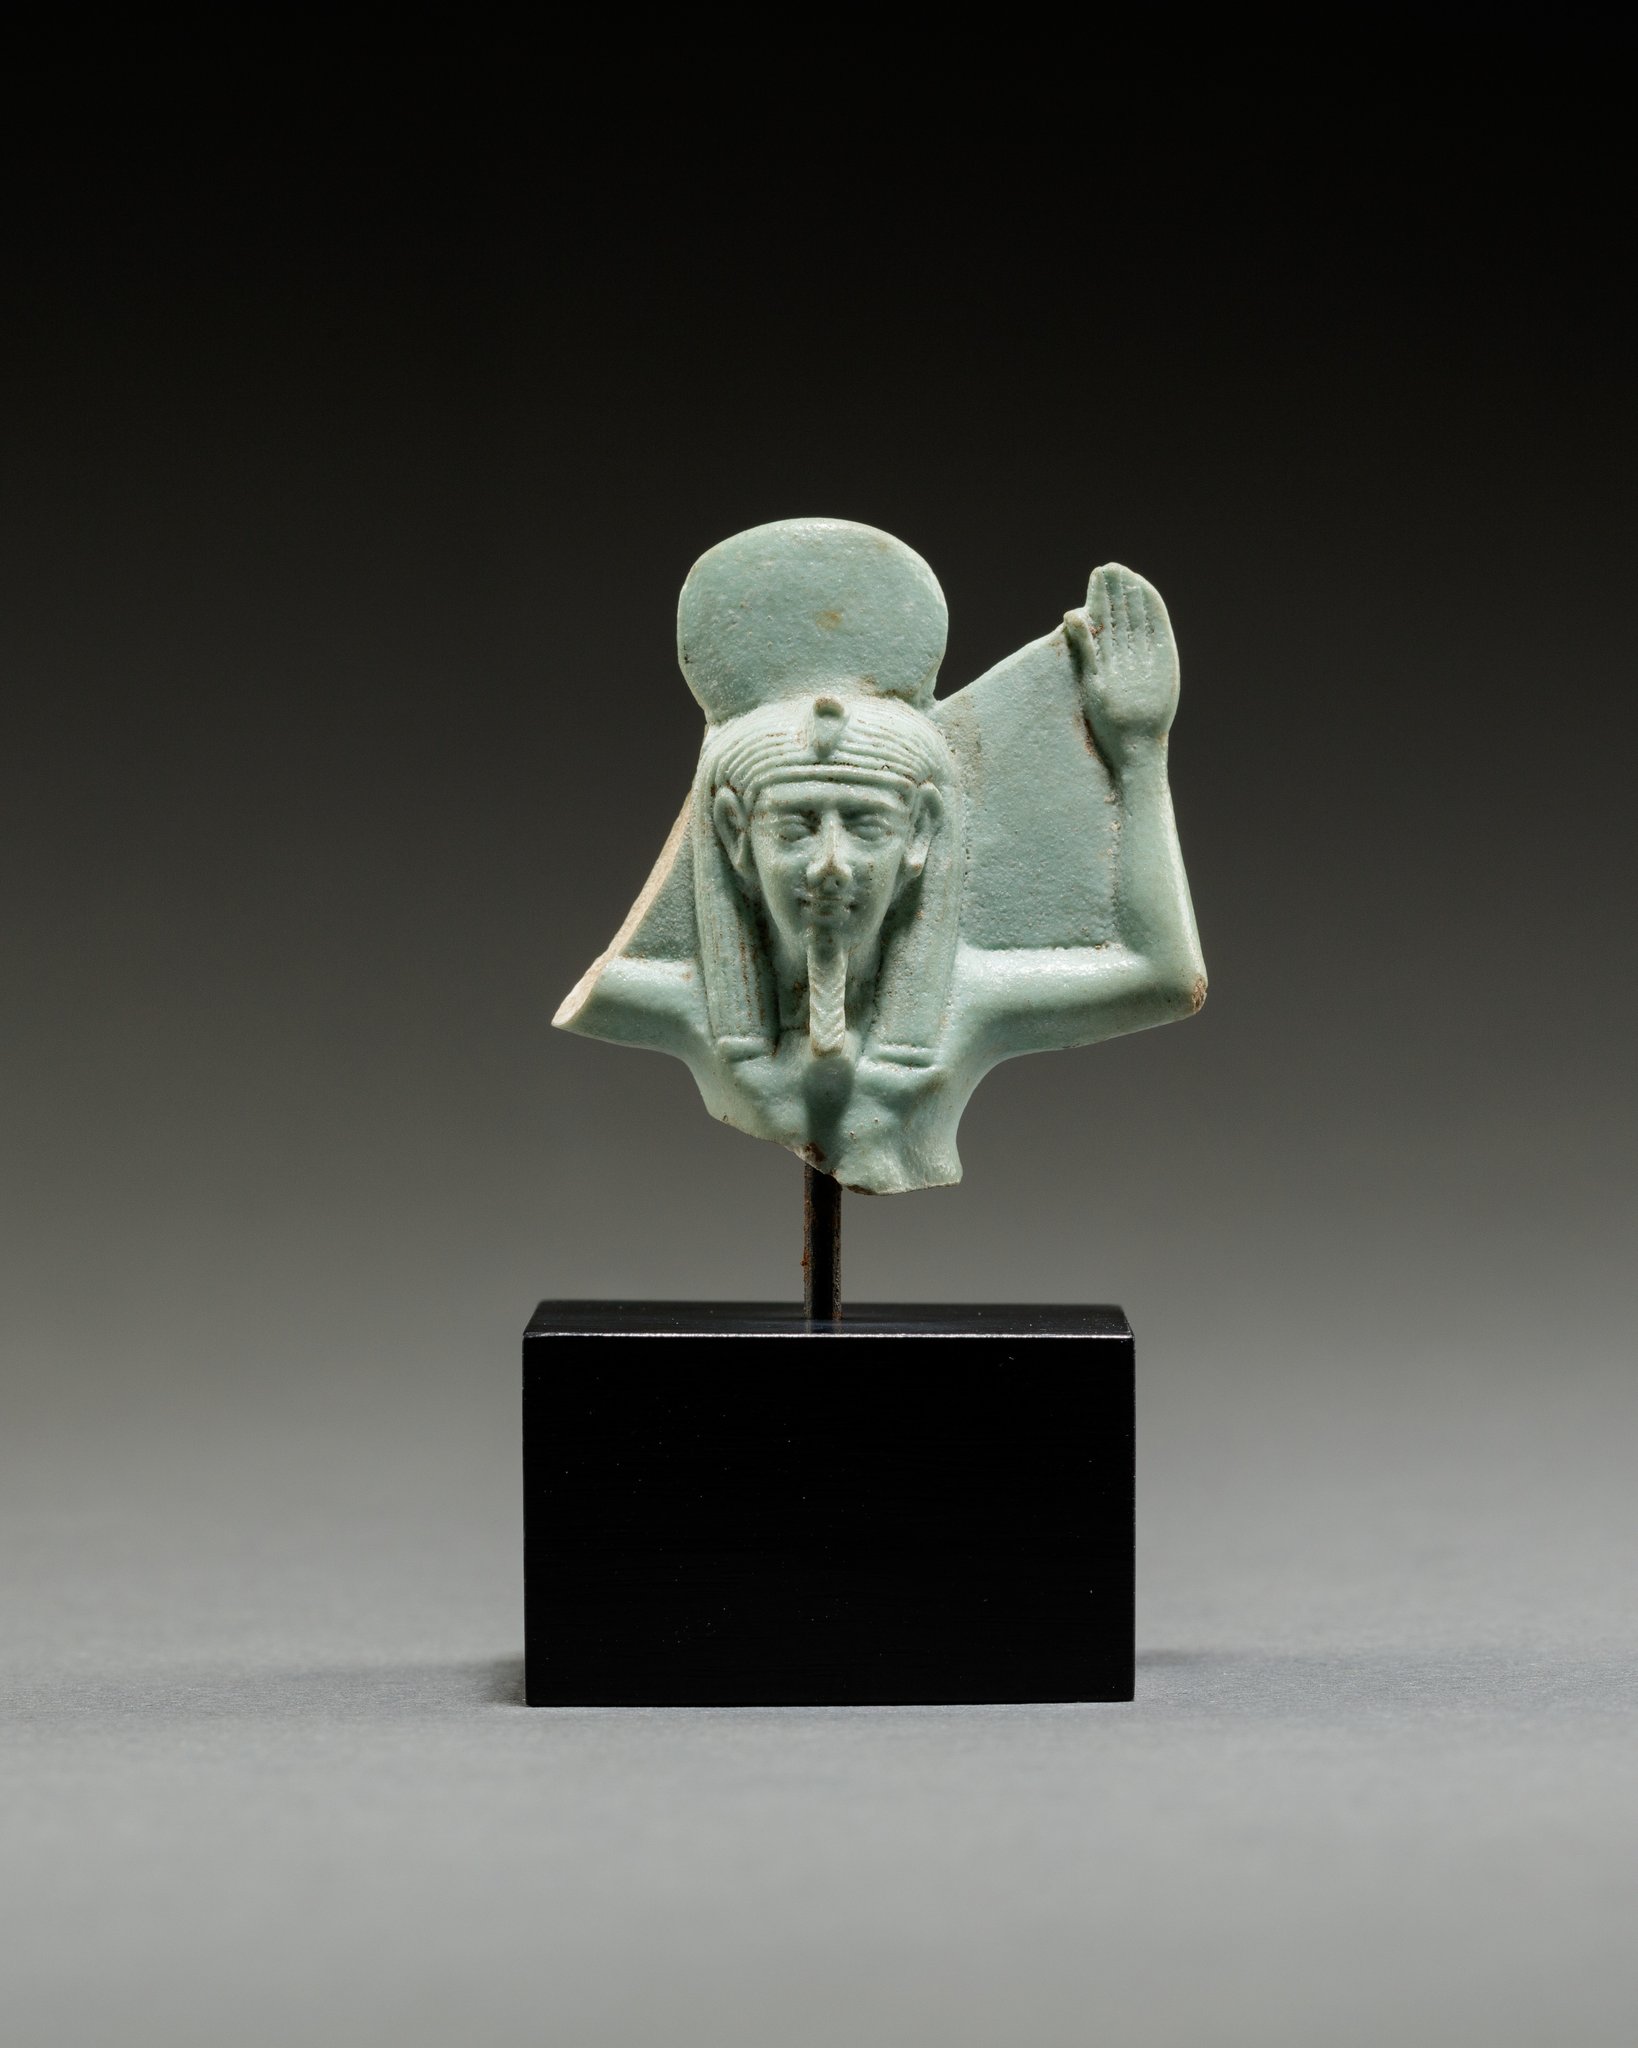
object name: partial shu amulet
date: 664-332 BCE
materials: faience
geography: egypt